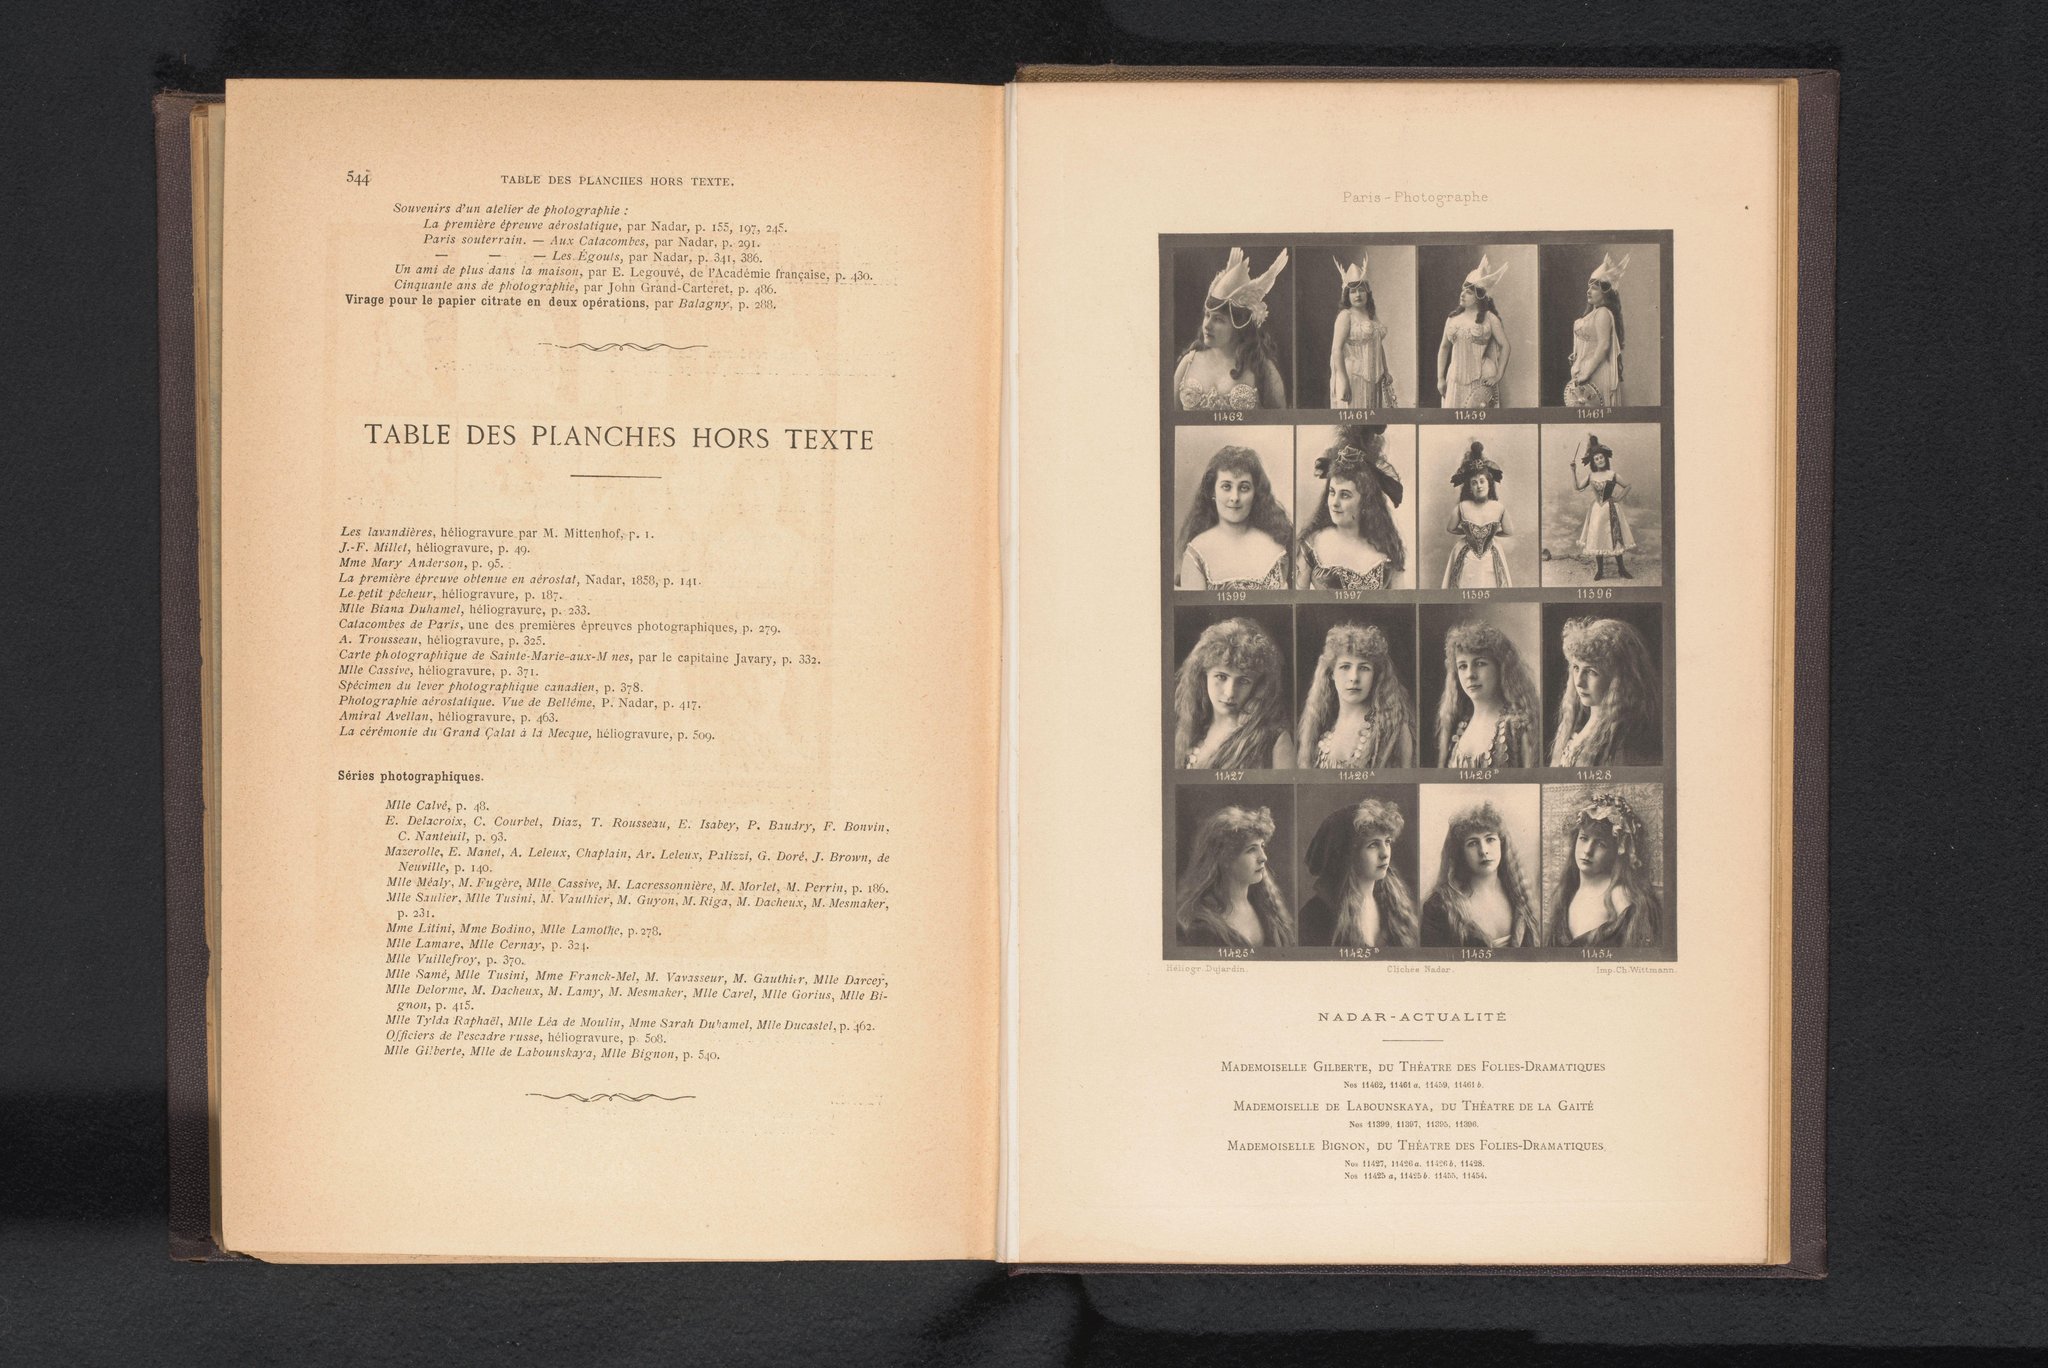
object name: photomechanical print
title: Zestien portretten van actrices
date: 1883-1893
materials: paper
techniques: photoaquatint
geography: france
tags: portrait of actor, actress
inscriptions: inscription: ‘Mademoiselle Gilberte (...)’, number: ‘11462 (...) 11454’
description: Van links naar rechts en van boven naar beneden: Mademoiselle Gilberte, Mademoiselle De Labounskaya en Mademoiselle Bignon.